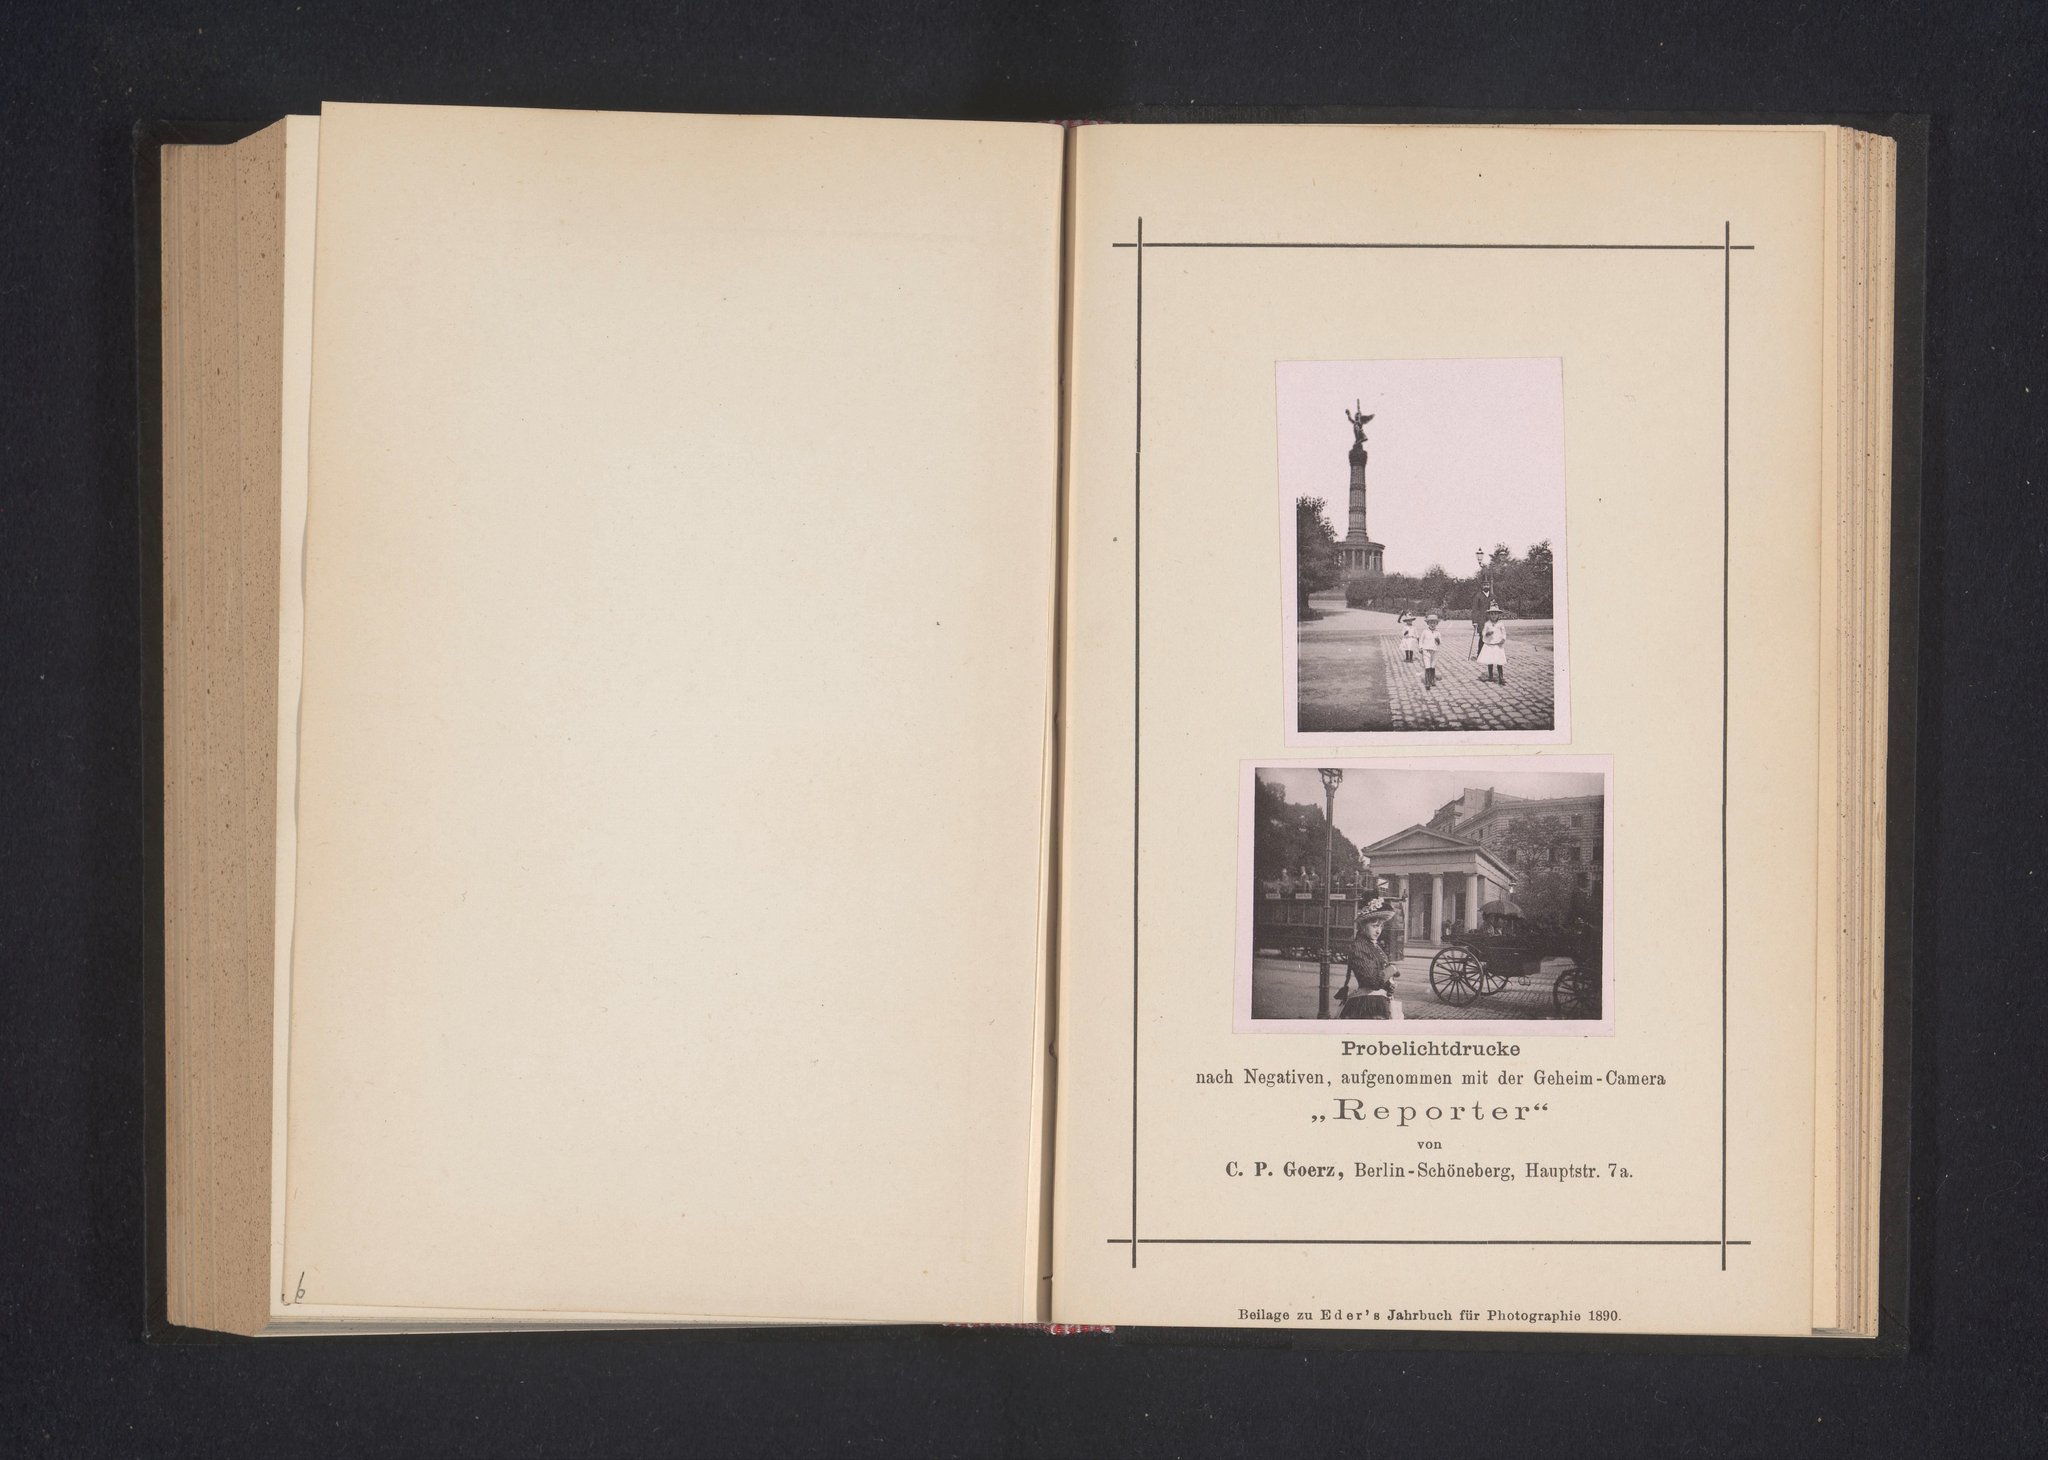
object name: photomechanical print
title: Twee straatgezichten in Berlijn, een met de Siegessäule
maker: Anonymous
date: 1885-1890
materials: paper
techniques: photograph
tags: monument, statue (+ city(-scape) with figures, staffage), street (+ city(-scape) with figures, staffage), berlin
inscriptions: inscription: ‘Probelichtdrucke/ nach Negativer, aufgenommen mit der Geheim-Camera "Reporter" von C.P. Goerz, Berlin-Schöneberg, Hauptstr. 7a./ Beilage zu Eder's Jahrbuch für Photographie 1890.’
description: Prent op vijftiende ongenummerde pagina na pagina 400.